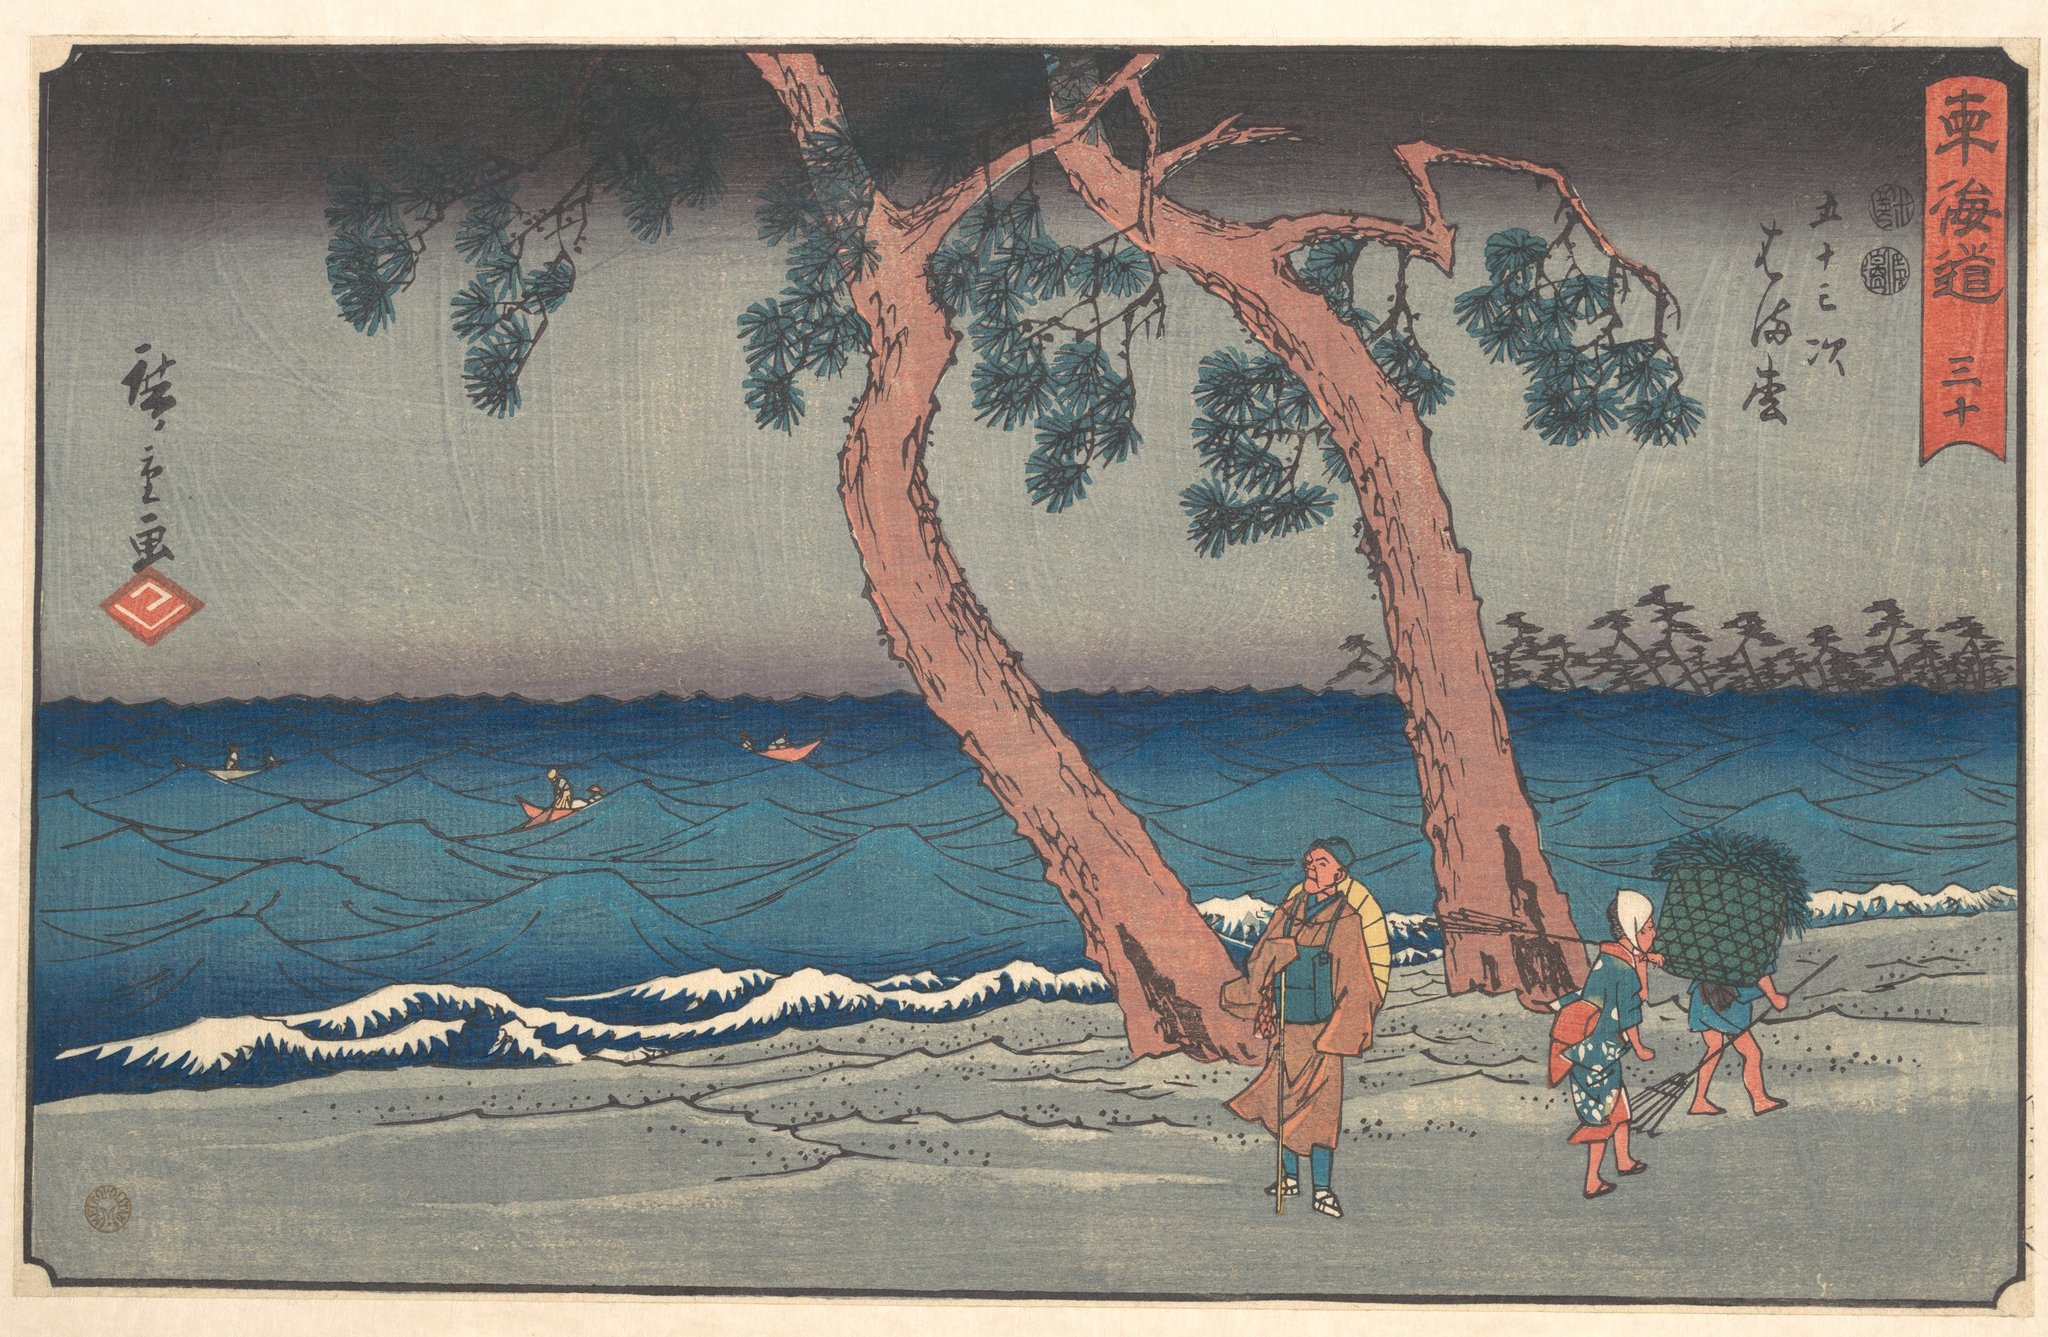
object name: print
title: Hamamatsu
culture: japanese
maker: utagawa hiroshige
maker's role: artist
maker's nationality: japanese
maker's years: 1797-1858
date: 1840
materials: ink, paper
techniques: woodblock print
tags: men,women,lakes,trees,boats